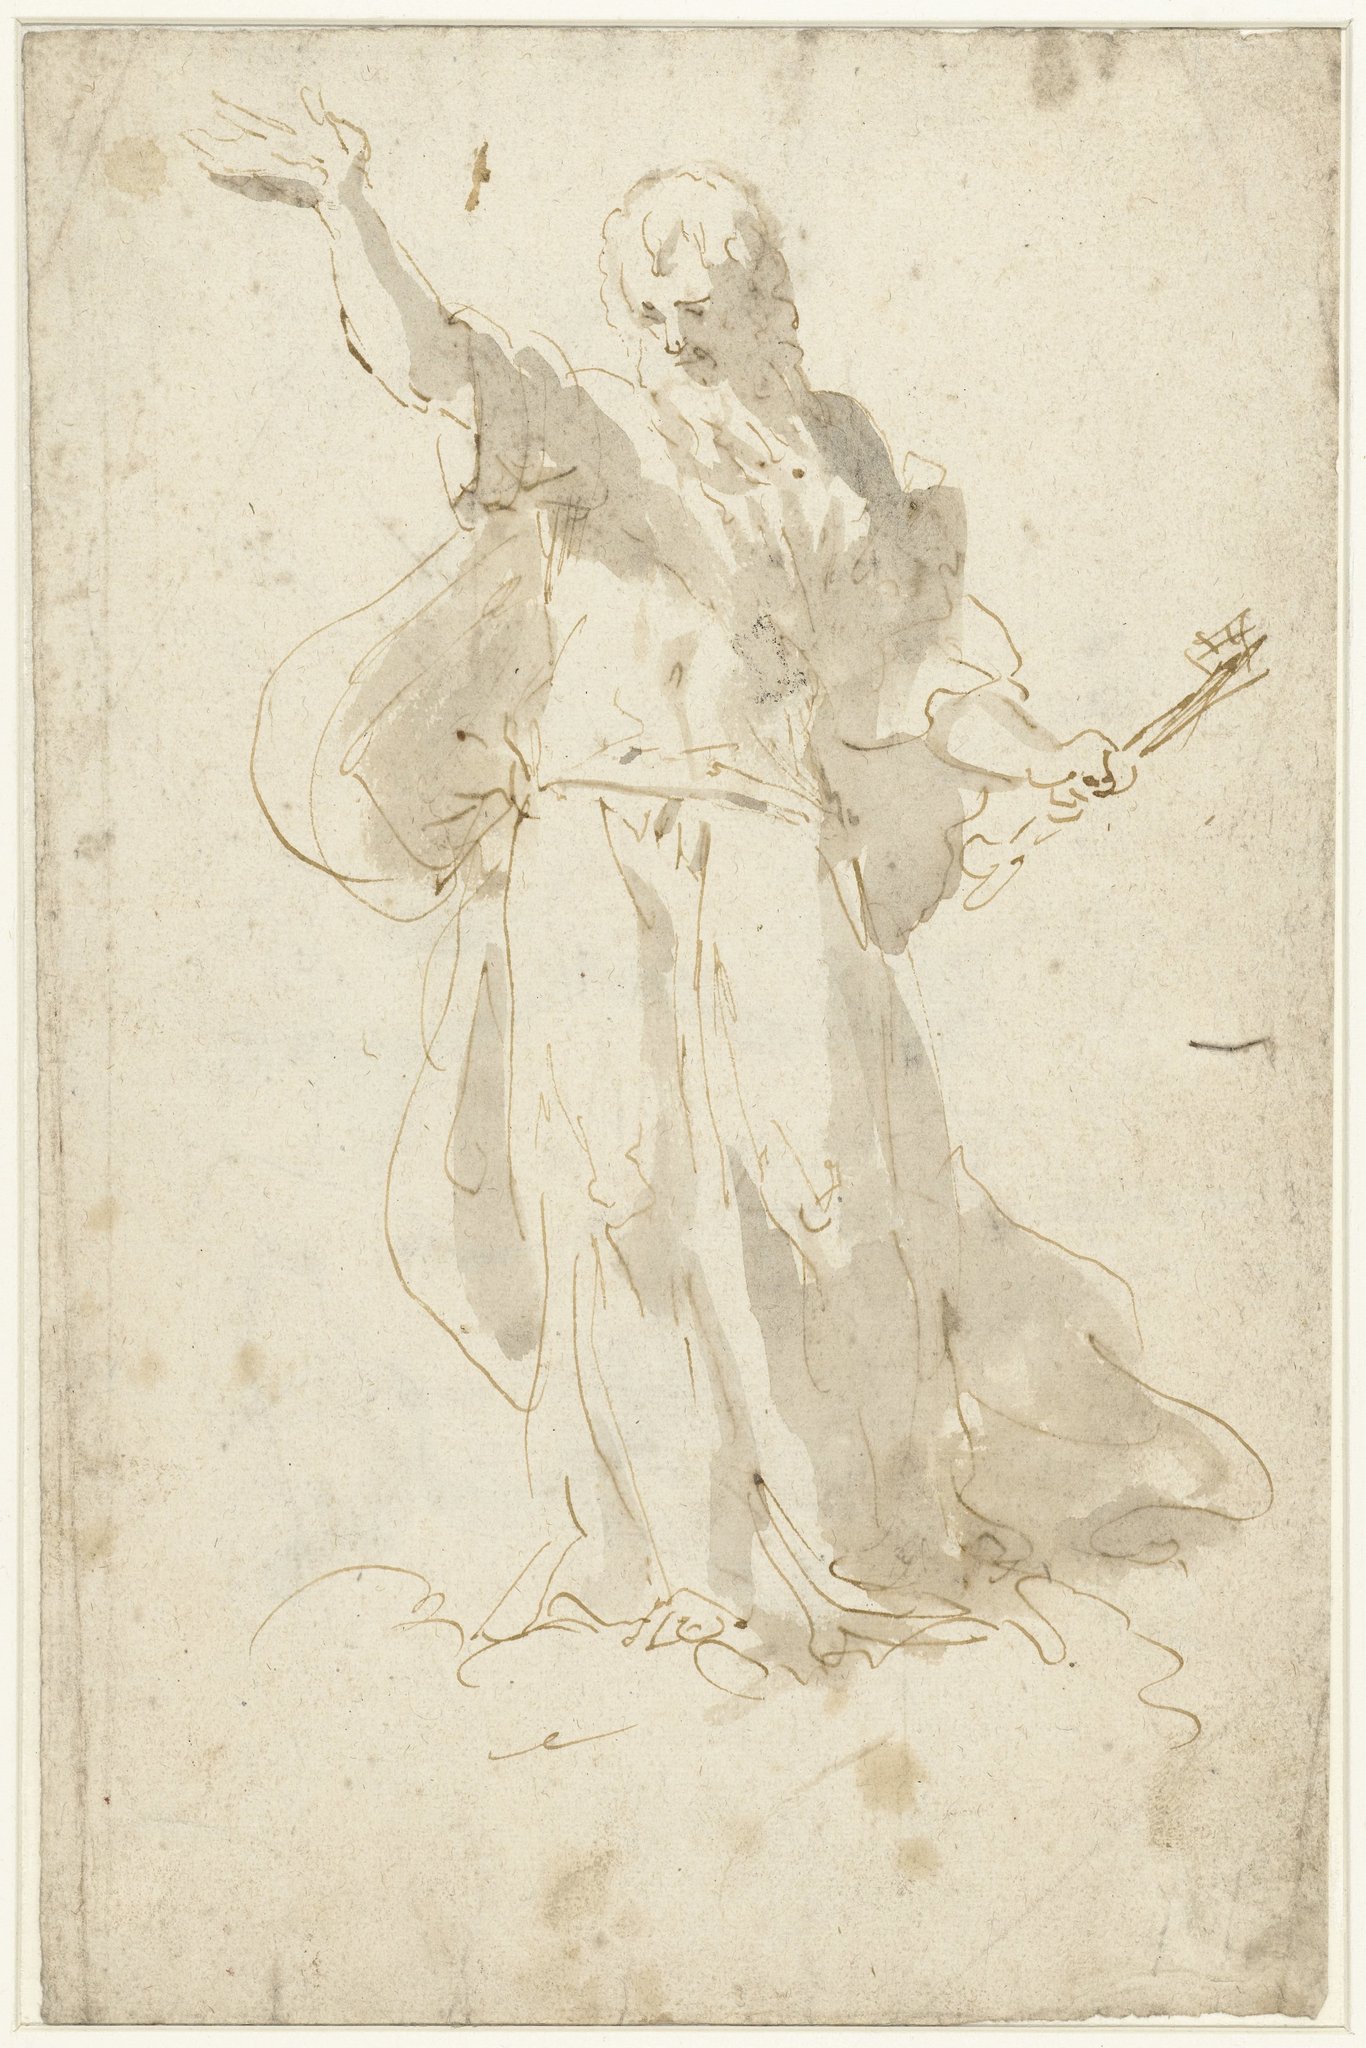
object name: drawing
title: Petrus op wolken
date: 1600-1699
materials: ink, paper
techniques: brush, pen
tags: the apostle peter, first bishop of rome; possible attributes: book, cock, (upturned) cross, (triple) crozier, fish, key, scroll, ship, tiara